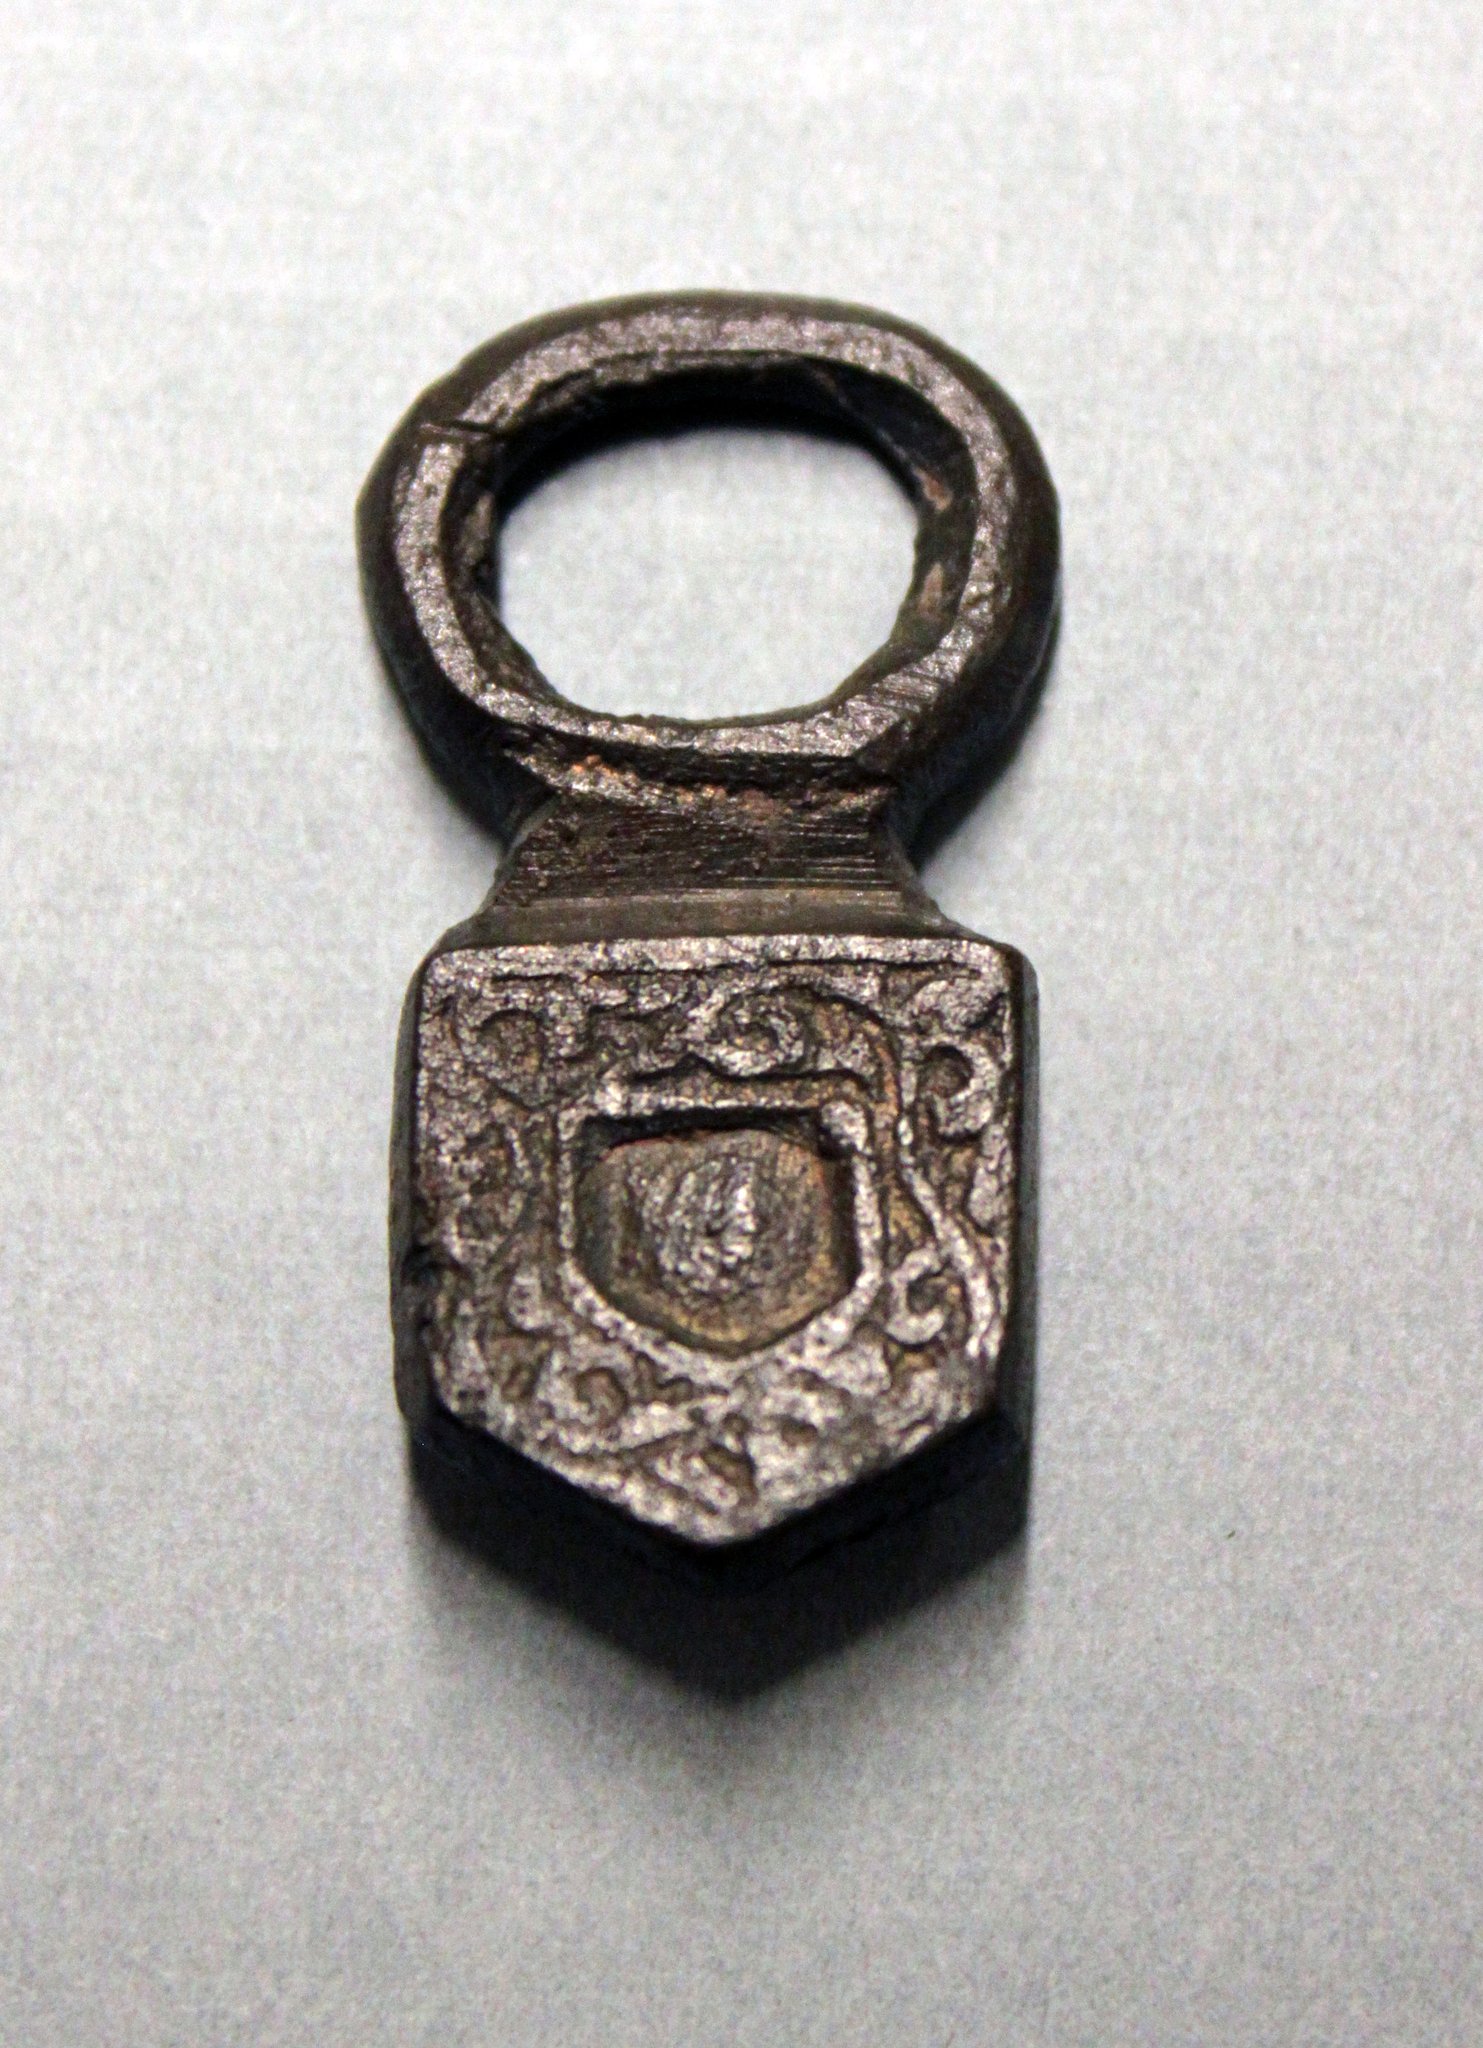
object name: belt fitting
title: Belt Fittings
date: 901-1100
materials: bronze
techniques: casting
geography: iran